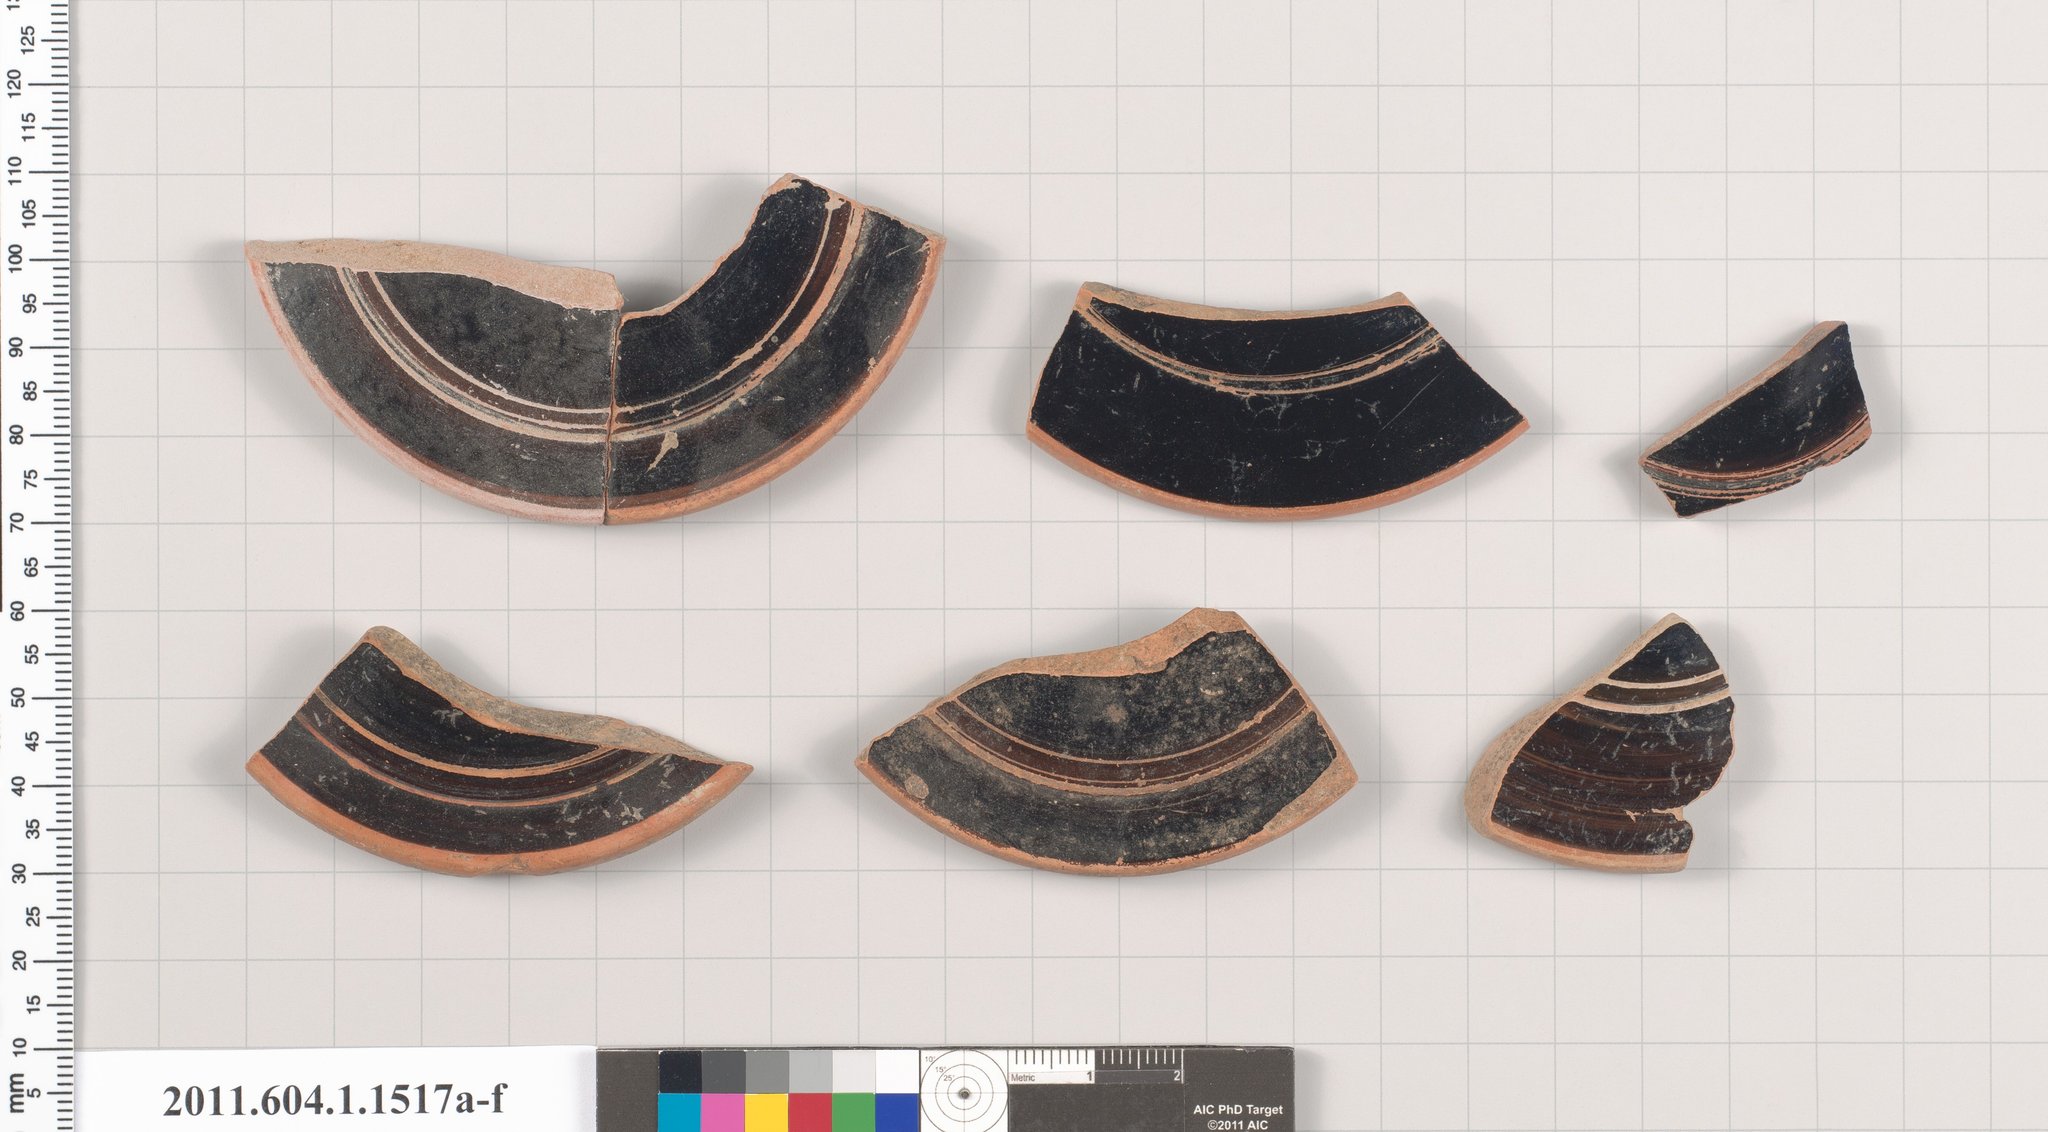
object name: kylix fragment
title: Terracotta fragments of kylikes (drinking cups)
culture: greek, attic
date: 500-401 BCE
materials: terracotta